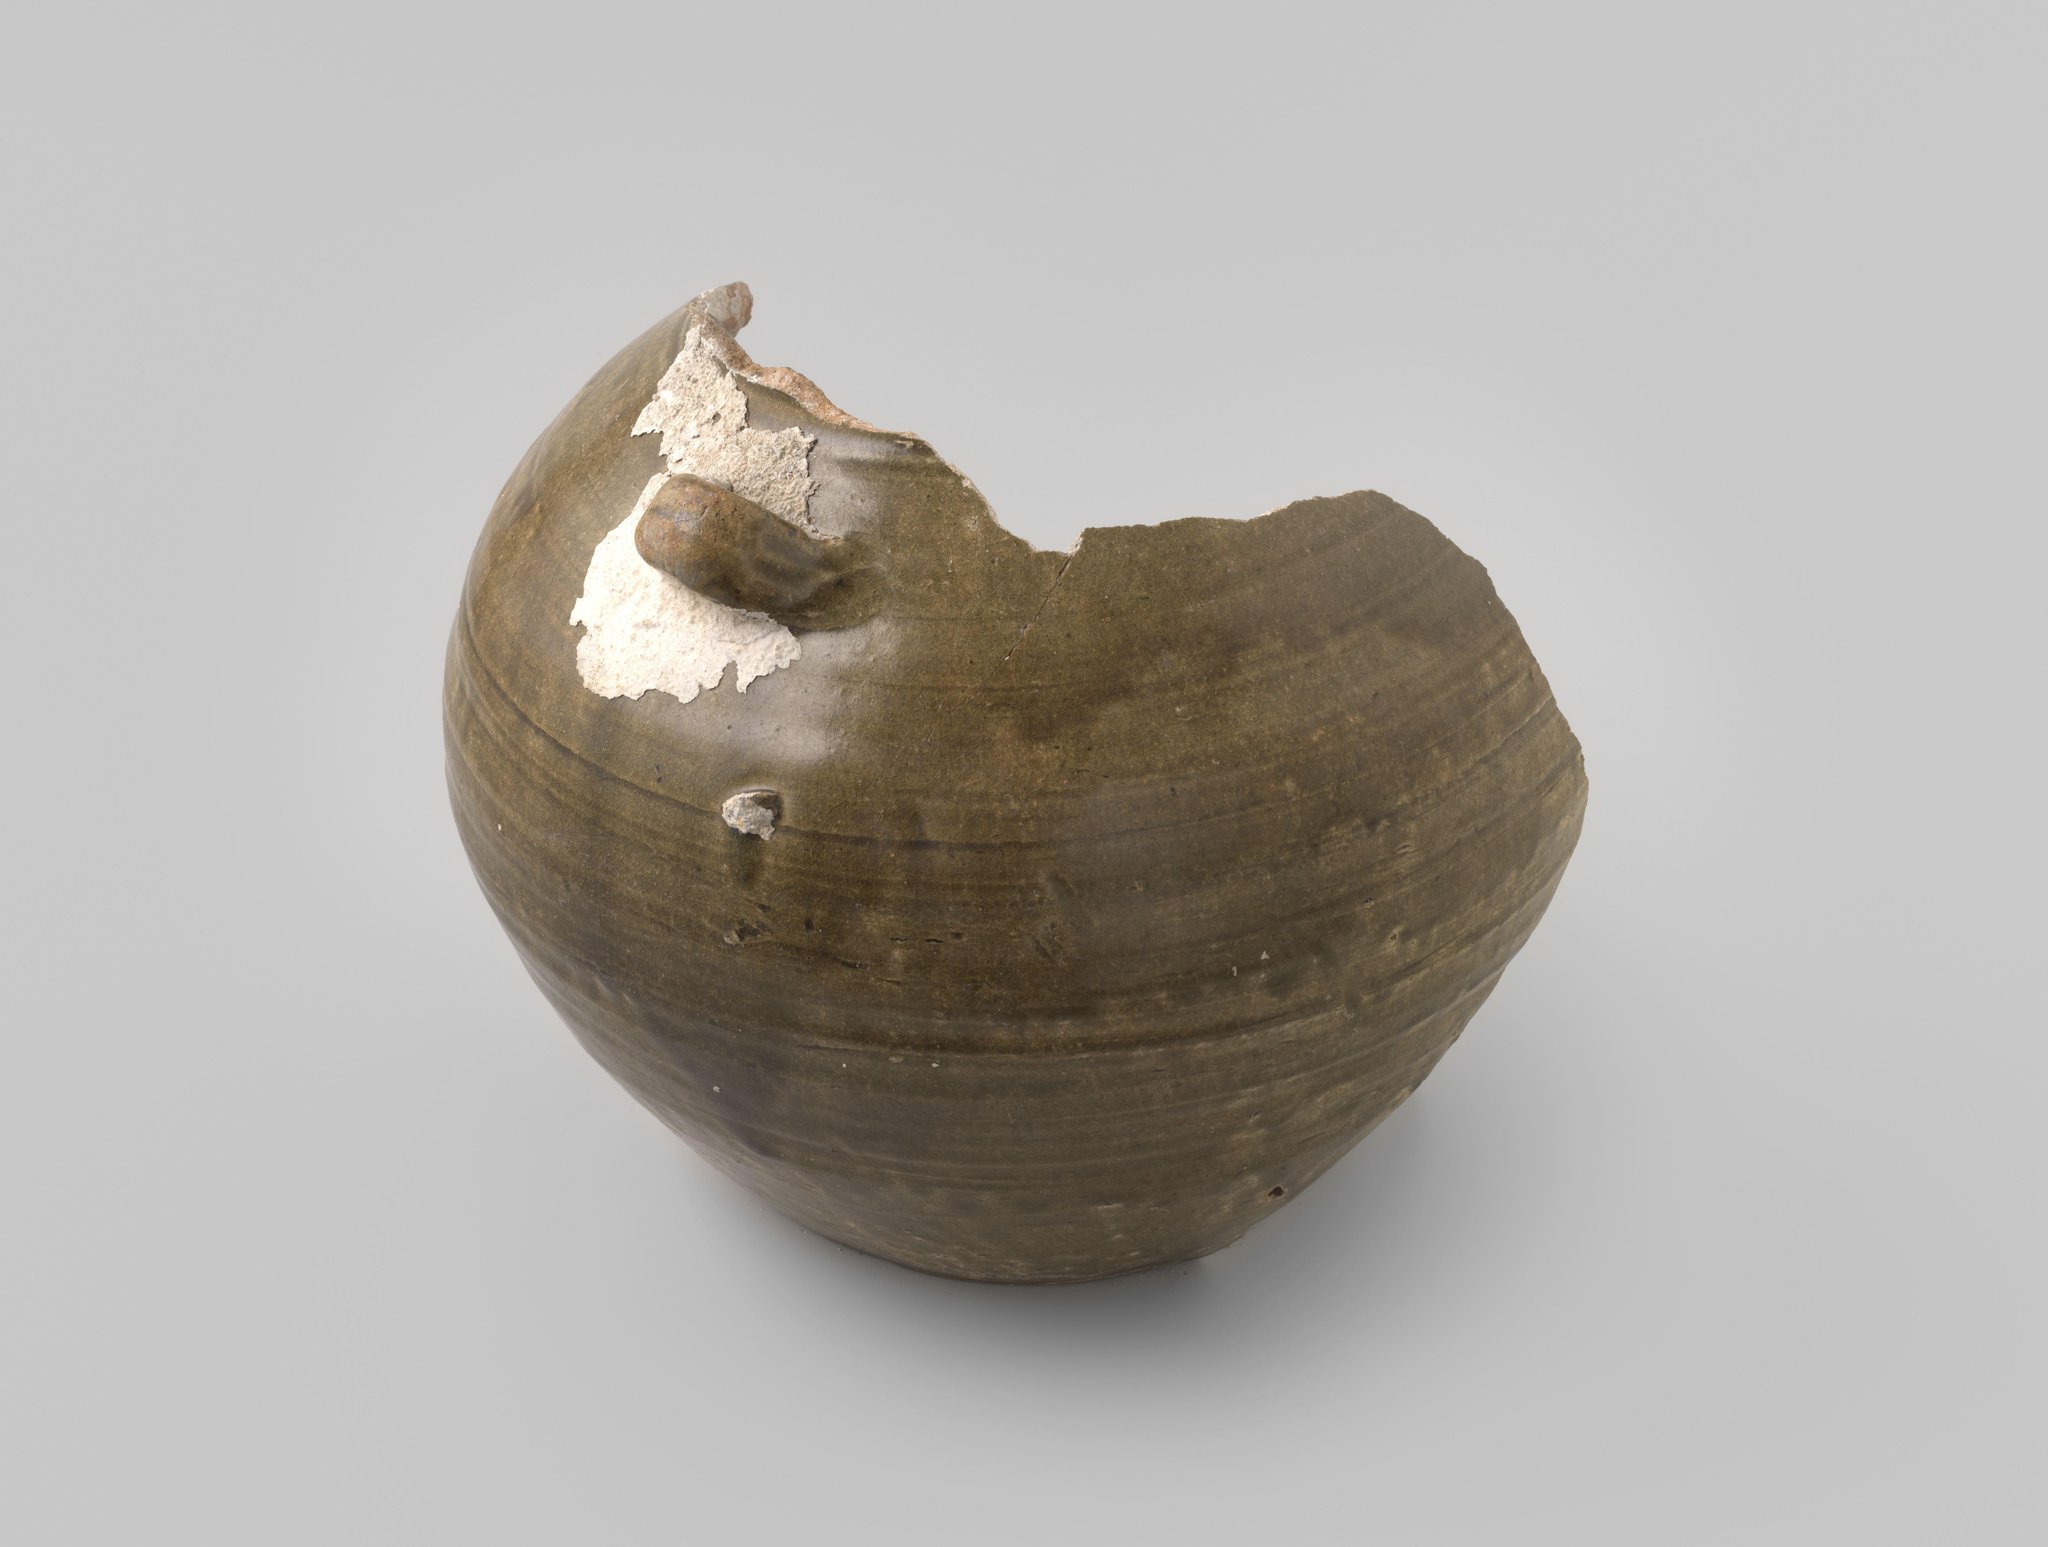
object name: vessel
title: Martavaan uit V.O.C.-schip de 'Witte Leeuw'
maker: Anonymous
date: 1613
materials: porcelain, stoneware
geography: southeast asia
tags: verenigde oostindische compagnie, sint-helena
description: A jar. The stoneware body is grey and cream coloured and has few black and white impurities. The spotted, sepia-coloured glaze covers the outside entirely and the inside of the lip and neck. From there, glaze drippings run out to the shoulder. The remainder of the inside of the jar is covered with a thin, brown coloured glaze. The lower part of the body has horizontal ripples as the jar has been made by the clay-coiling method.